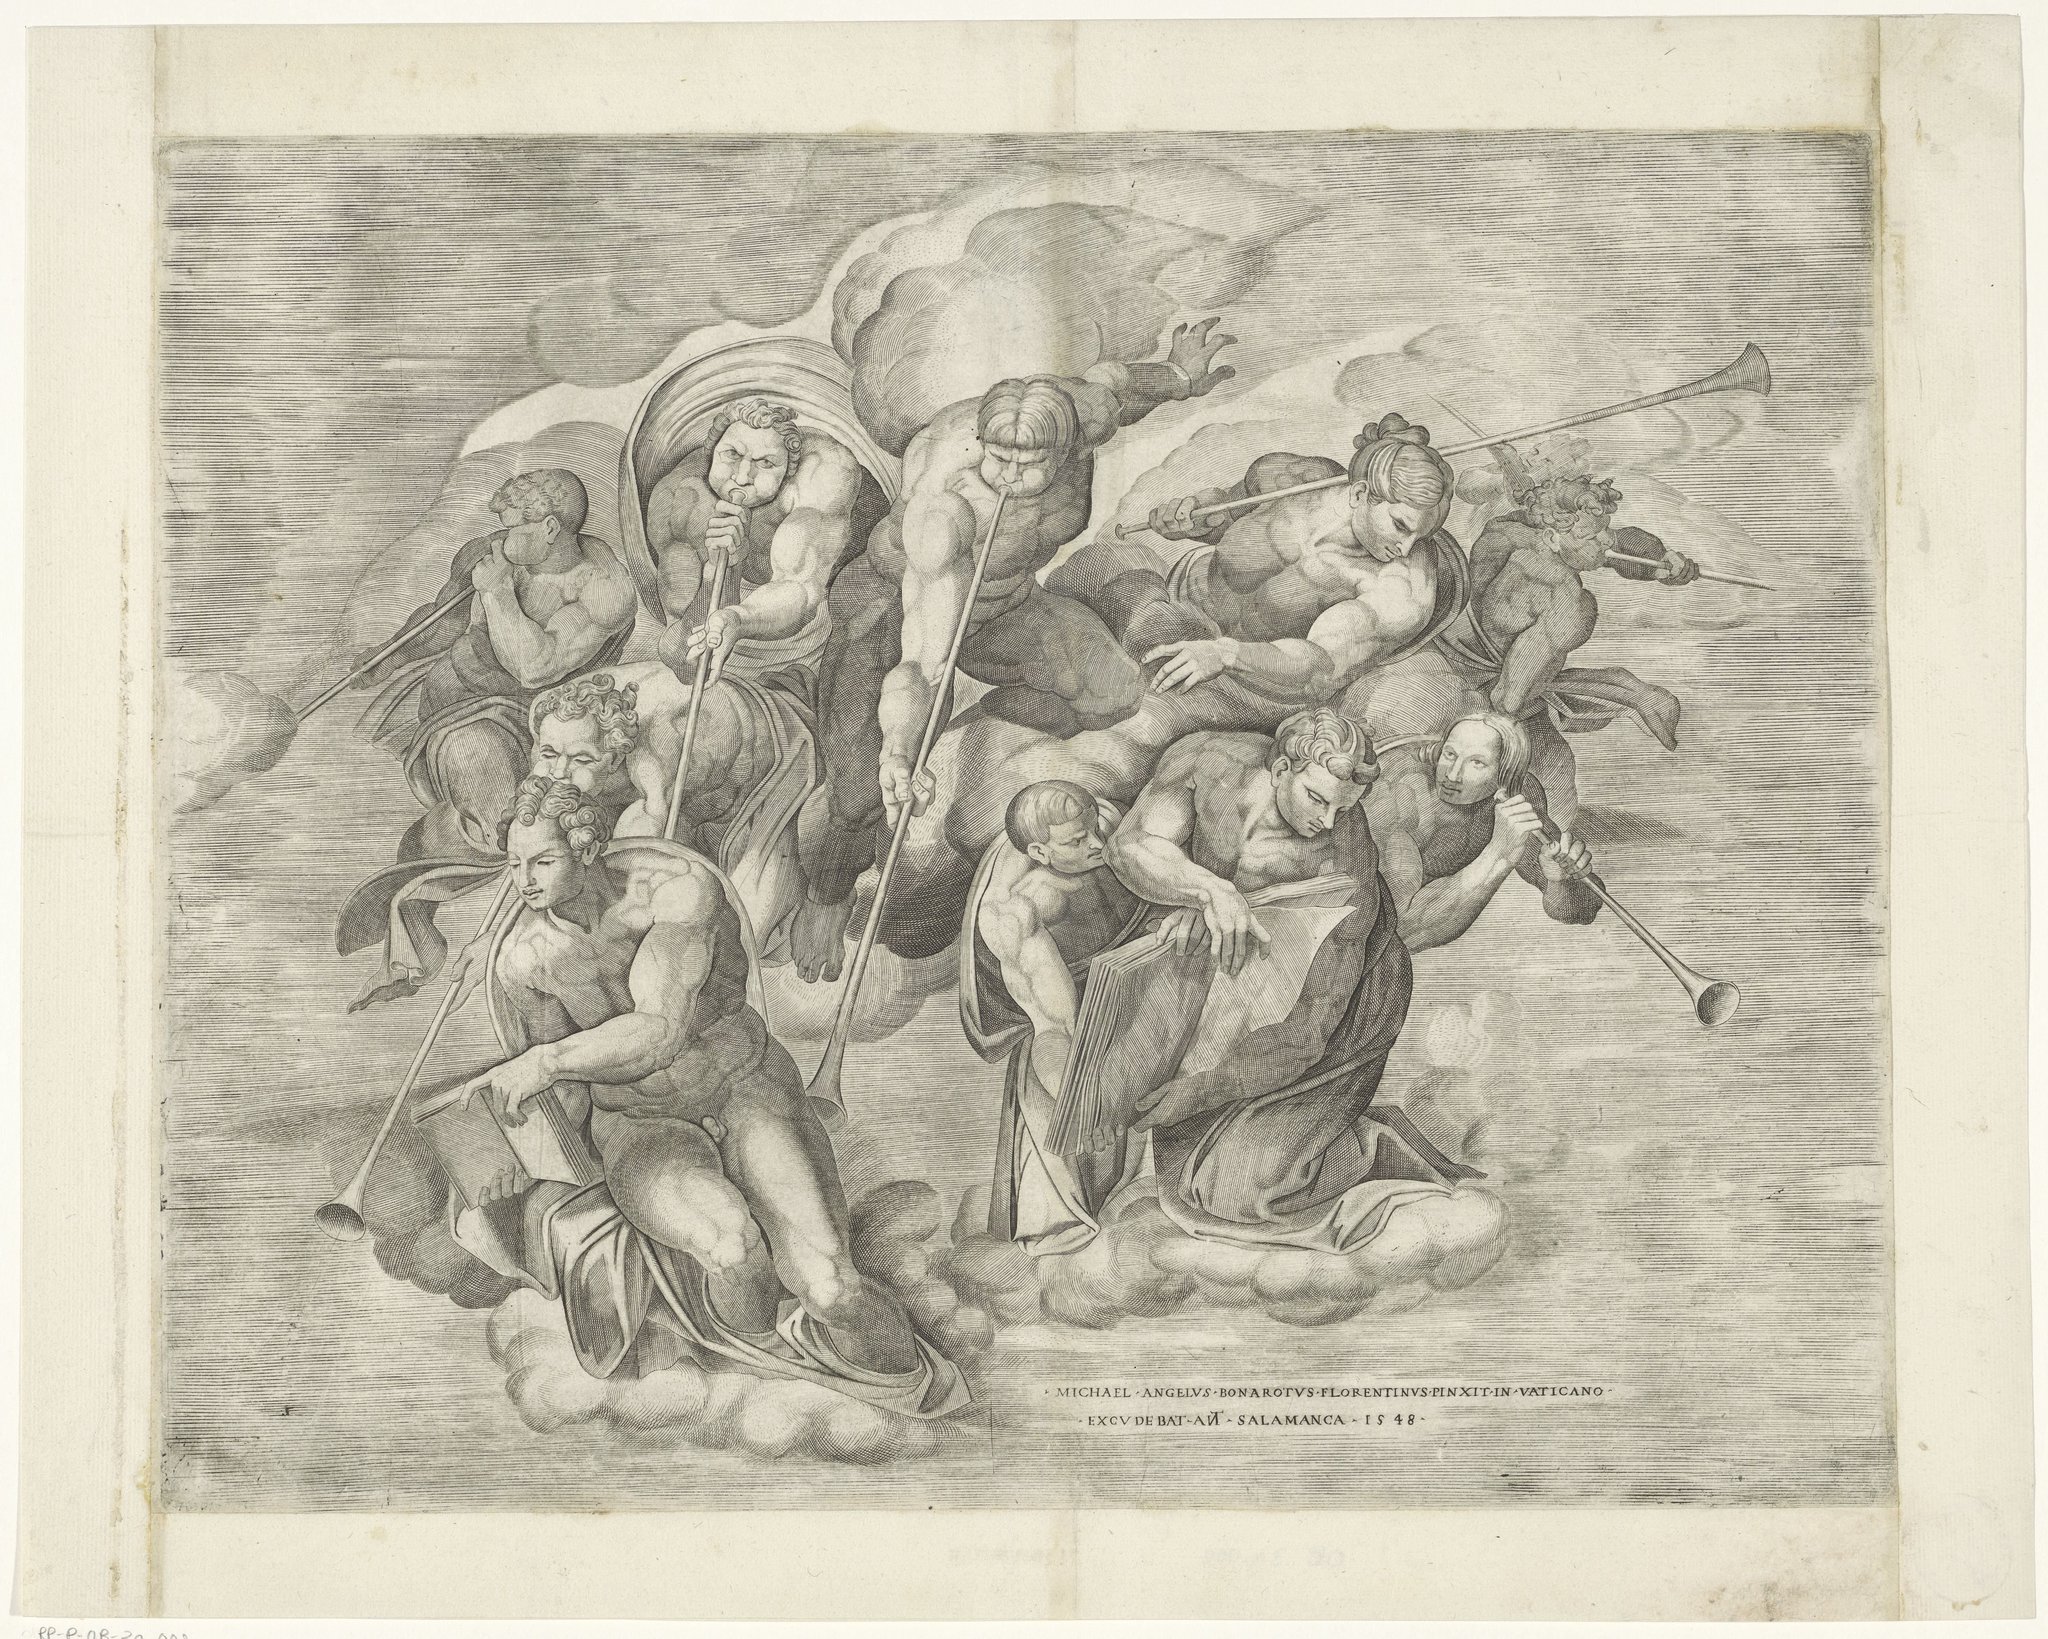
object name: print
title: Het laatste oordeel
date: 1548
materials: paper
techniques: engraving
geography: italy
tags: last judgement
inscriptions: collector's mark: Lugt 240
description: Prent maakt deel uit van een groep van twaalf prenten die samen één grote voorstelling vormen naar het fresco met het Laatste Oordeel door Michelangelo in de Sixtijnse Kapel in het Vaticaan.